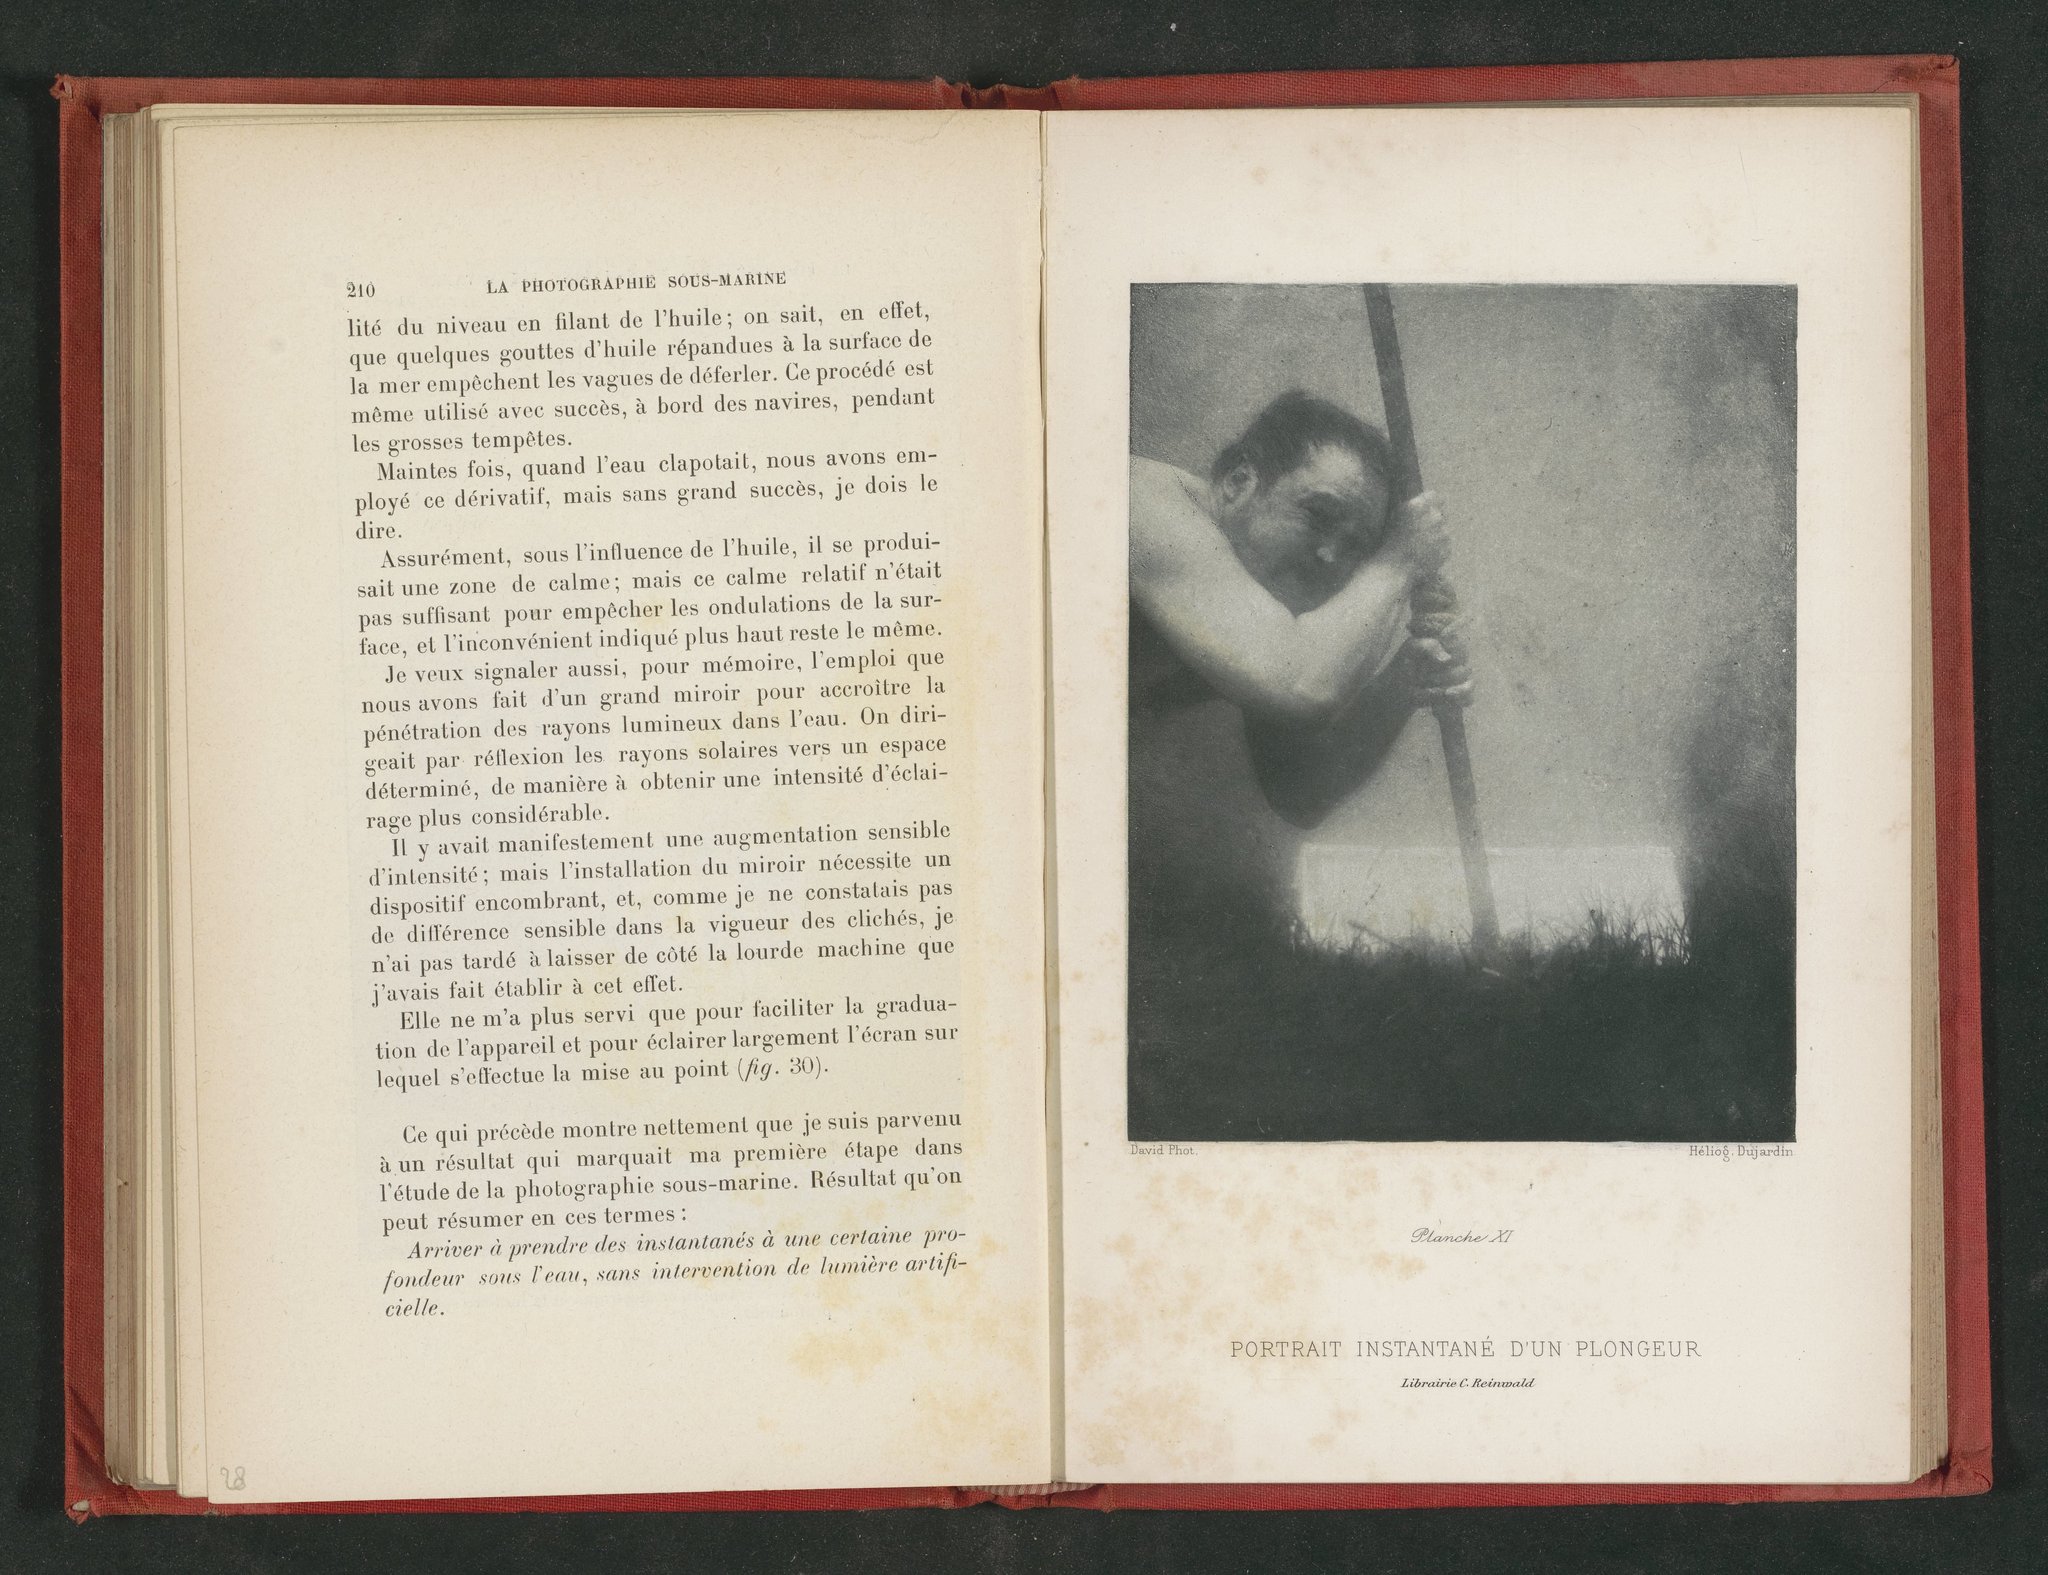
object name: photomechanical print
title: Onderwaterportret van Louis Boutan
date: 1890-1900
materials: paper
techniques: autotype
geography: france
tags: louis boutan, diving (movement in water)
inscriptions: inscription: ‘Librairie C. Reinwald’, number: ‘Planche XI’